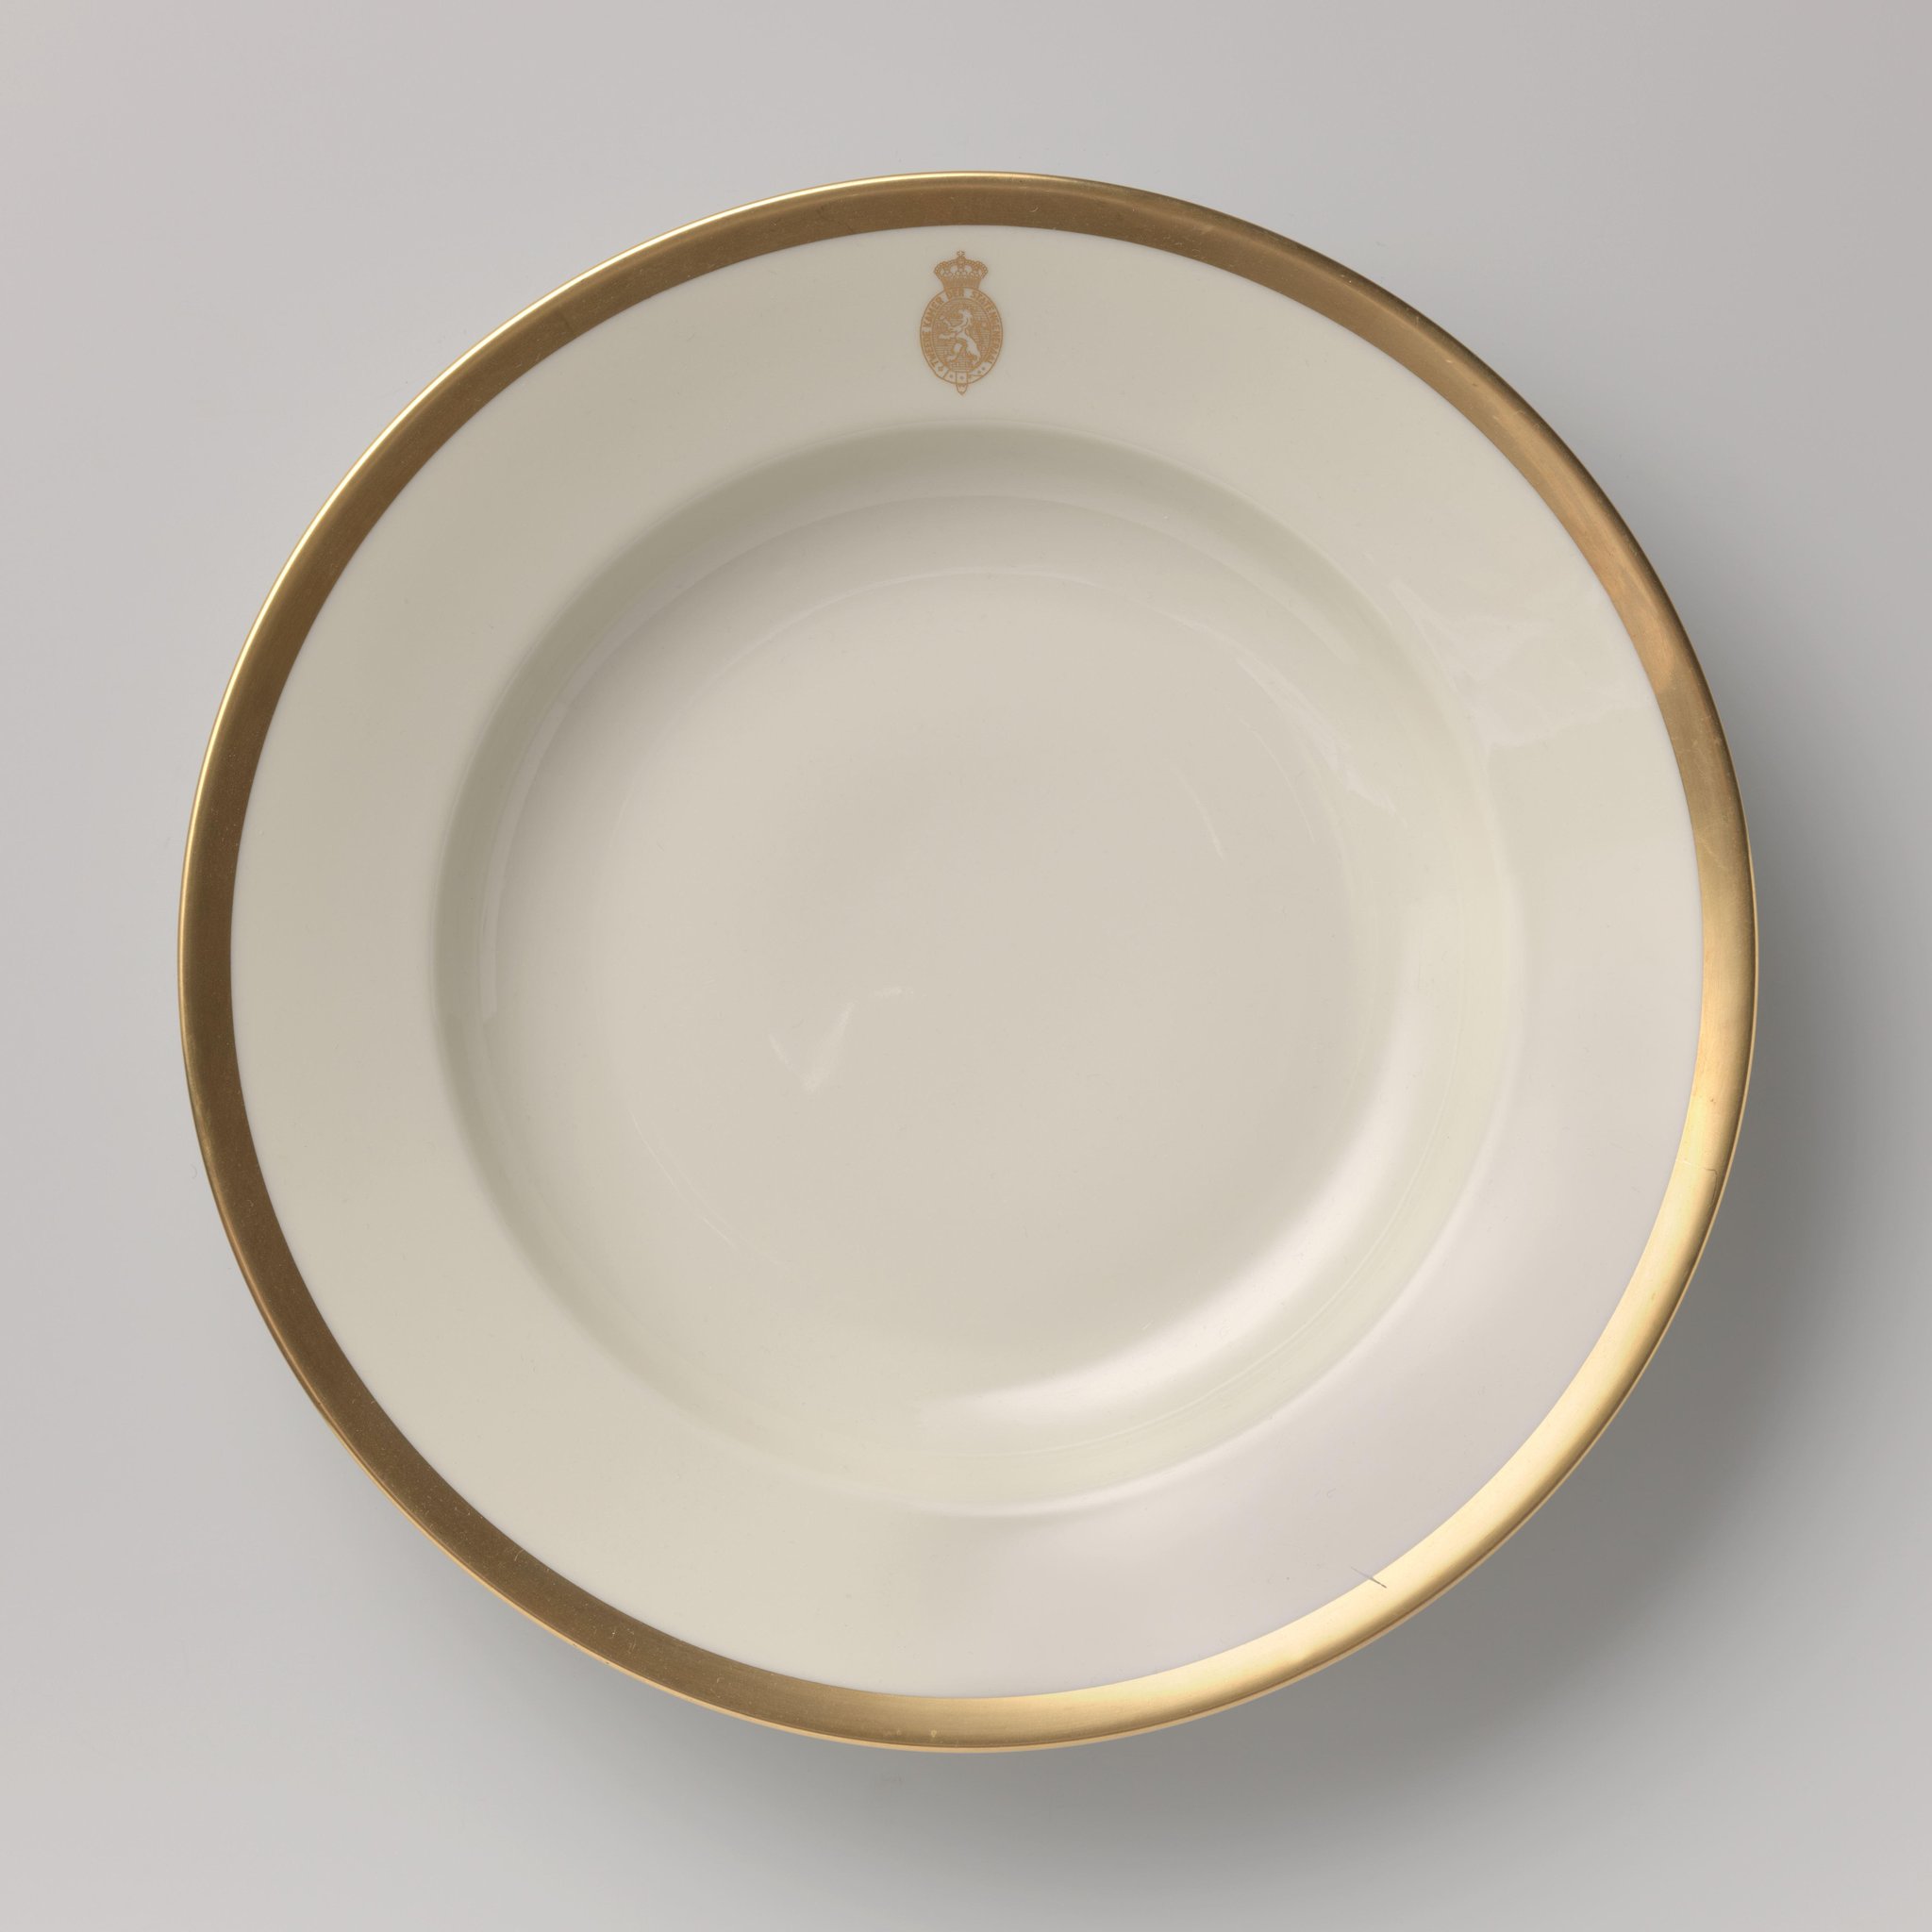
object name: plate dish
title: Plate used in the House of Representatives of the Netherlands at official receptions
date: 1900-1974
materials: glaze, gold, paint, porcelain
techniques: firing, forming, vitrification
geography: bavaria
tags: brussels, the hague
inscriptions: inscription: ‘TWEEDE KAMER DER STATENGENERAAL’, mark: ‘Hutschenreuther Selb/ leeuw met L.H.S. Bavaria Germany/ N/ P.A.W. Philippona Den Haag/ 25’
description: Diep bord van porselein, beschilderd op het glazuur in goud. Versierd met een gouden rand en het gekroonde wapen van de Tweede Kamer met het opschrift 'TWEEDE KAMER DER STATENGENERAAL'. Gemerkt op de onderzijde met het fabrieksmerk, 'P.A.W. PHILIPPONA DEN HAAG', N en 25. Mogelijk gedecoreerd in Den Haag.